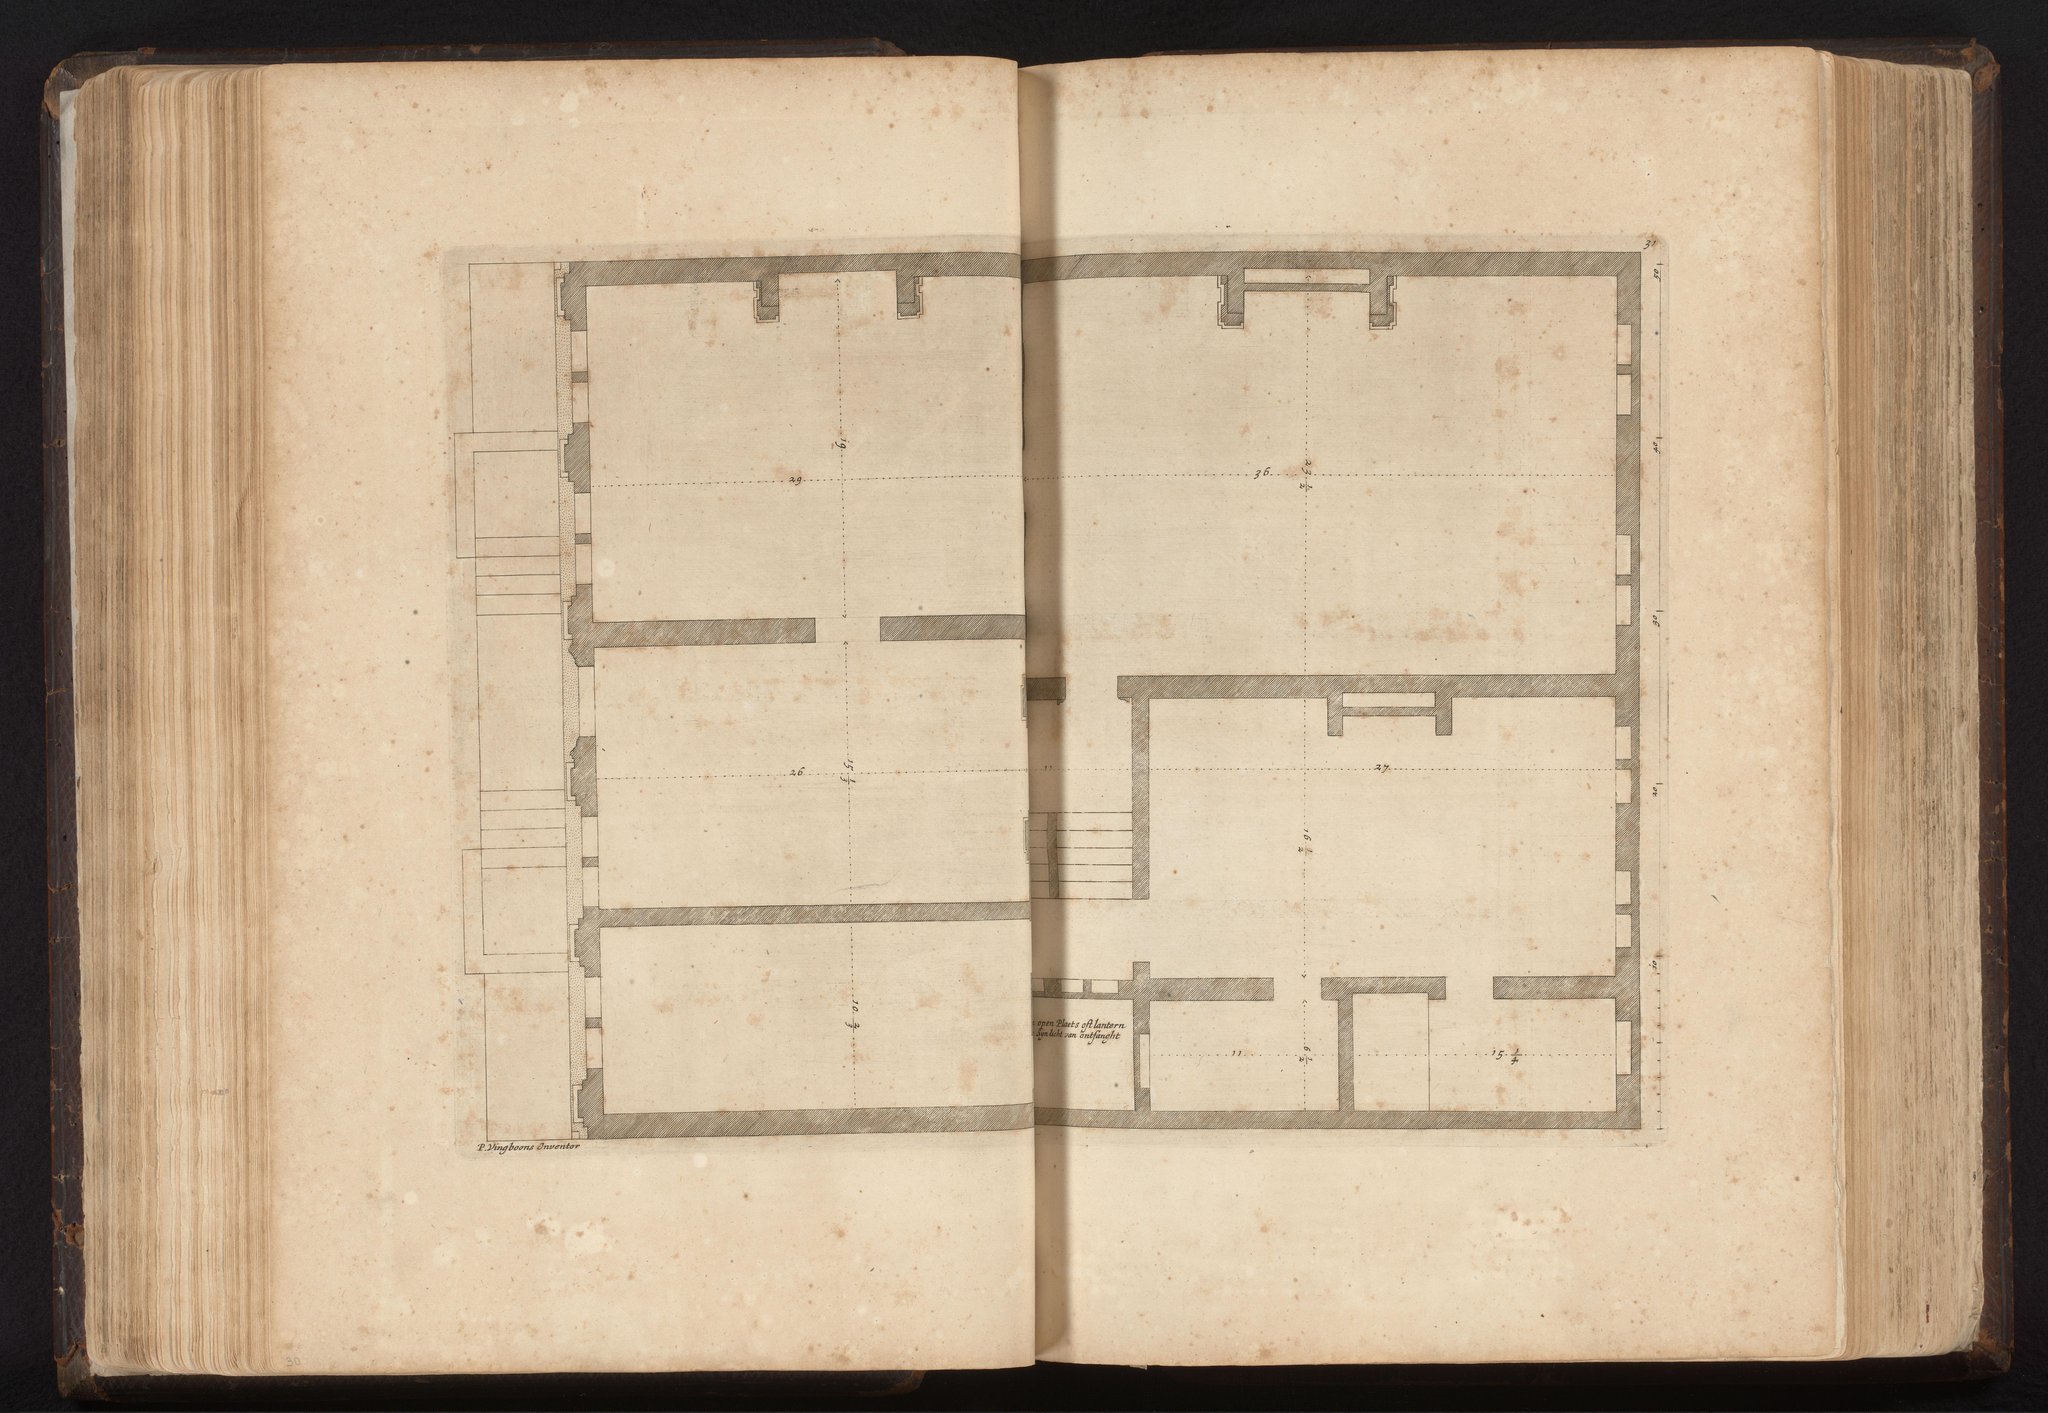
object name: print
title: Plattegrond van de eerste verdieping van een huis aan de Singel te Amsterdam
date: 1648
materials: paper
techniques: engraving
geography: amsterdam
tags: plan ~ architecture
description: Prent uit: Afbeelsels der voornaemste gebouwen uyt alle die Philips Vingboons geordineert heeft. Amsterdam: Philips en Johannes Vinckboons en Johannes Willemszoon Blaeu, 1648.